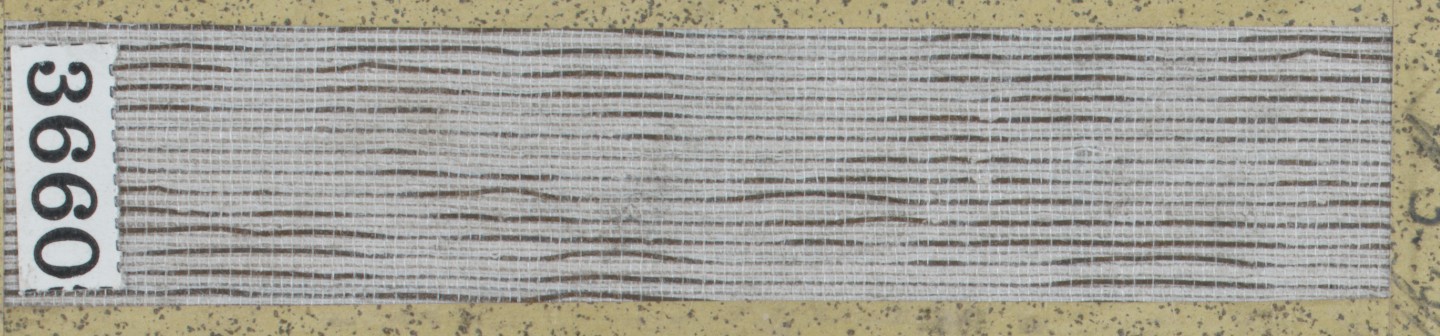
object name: sample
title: Textile Sample from Sample Book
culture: japanese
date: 1801-1900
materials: silk